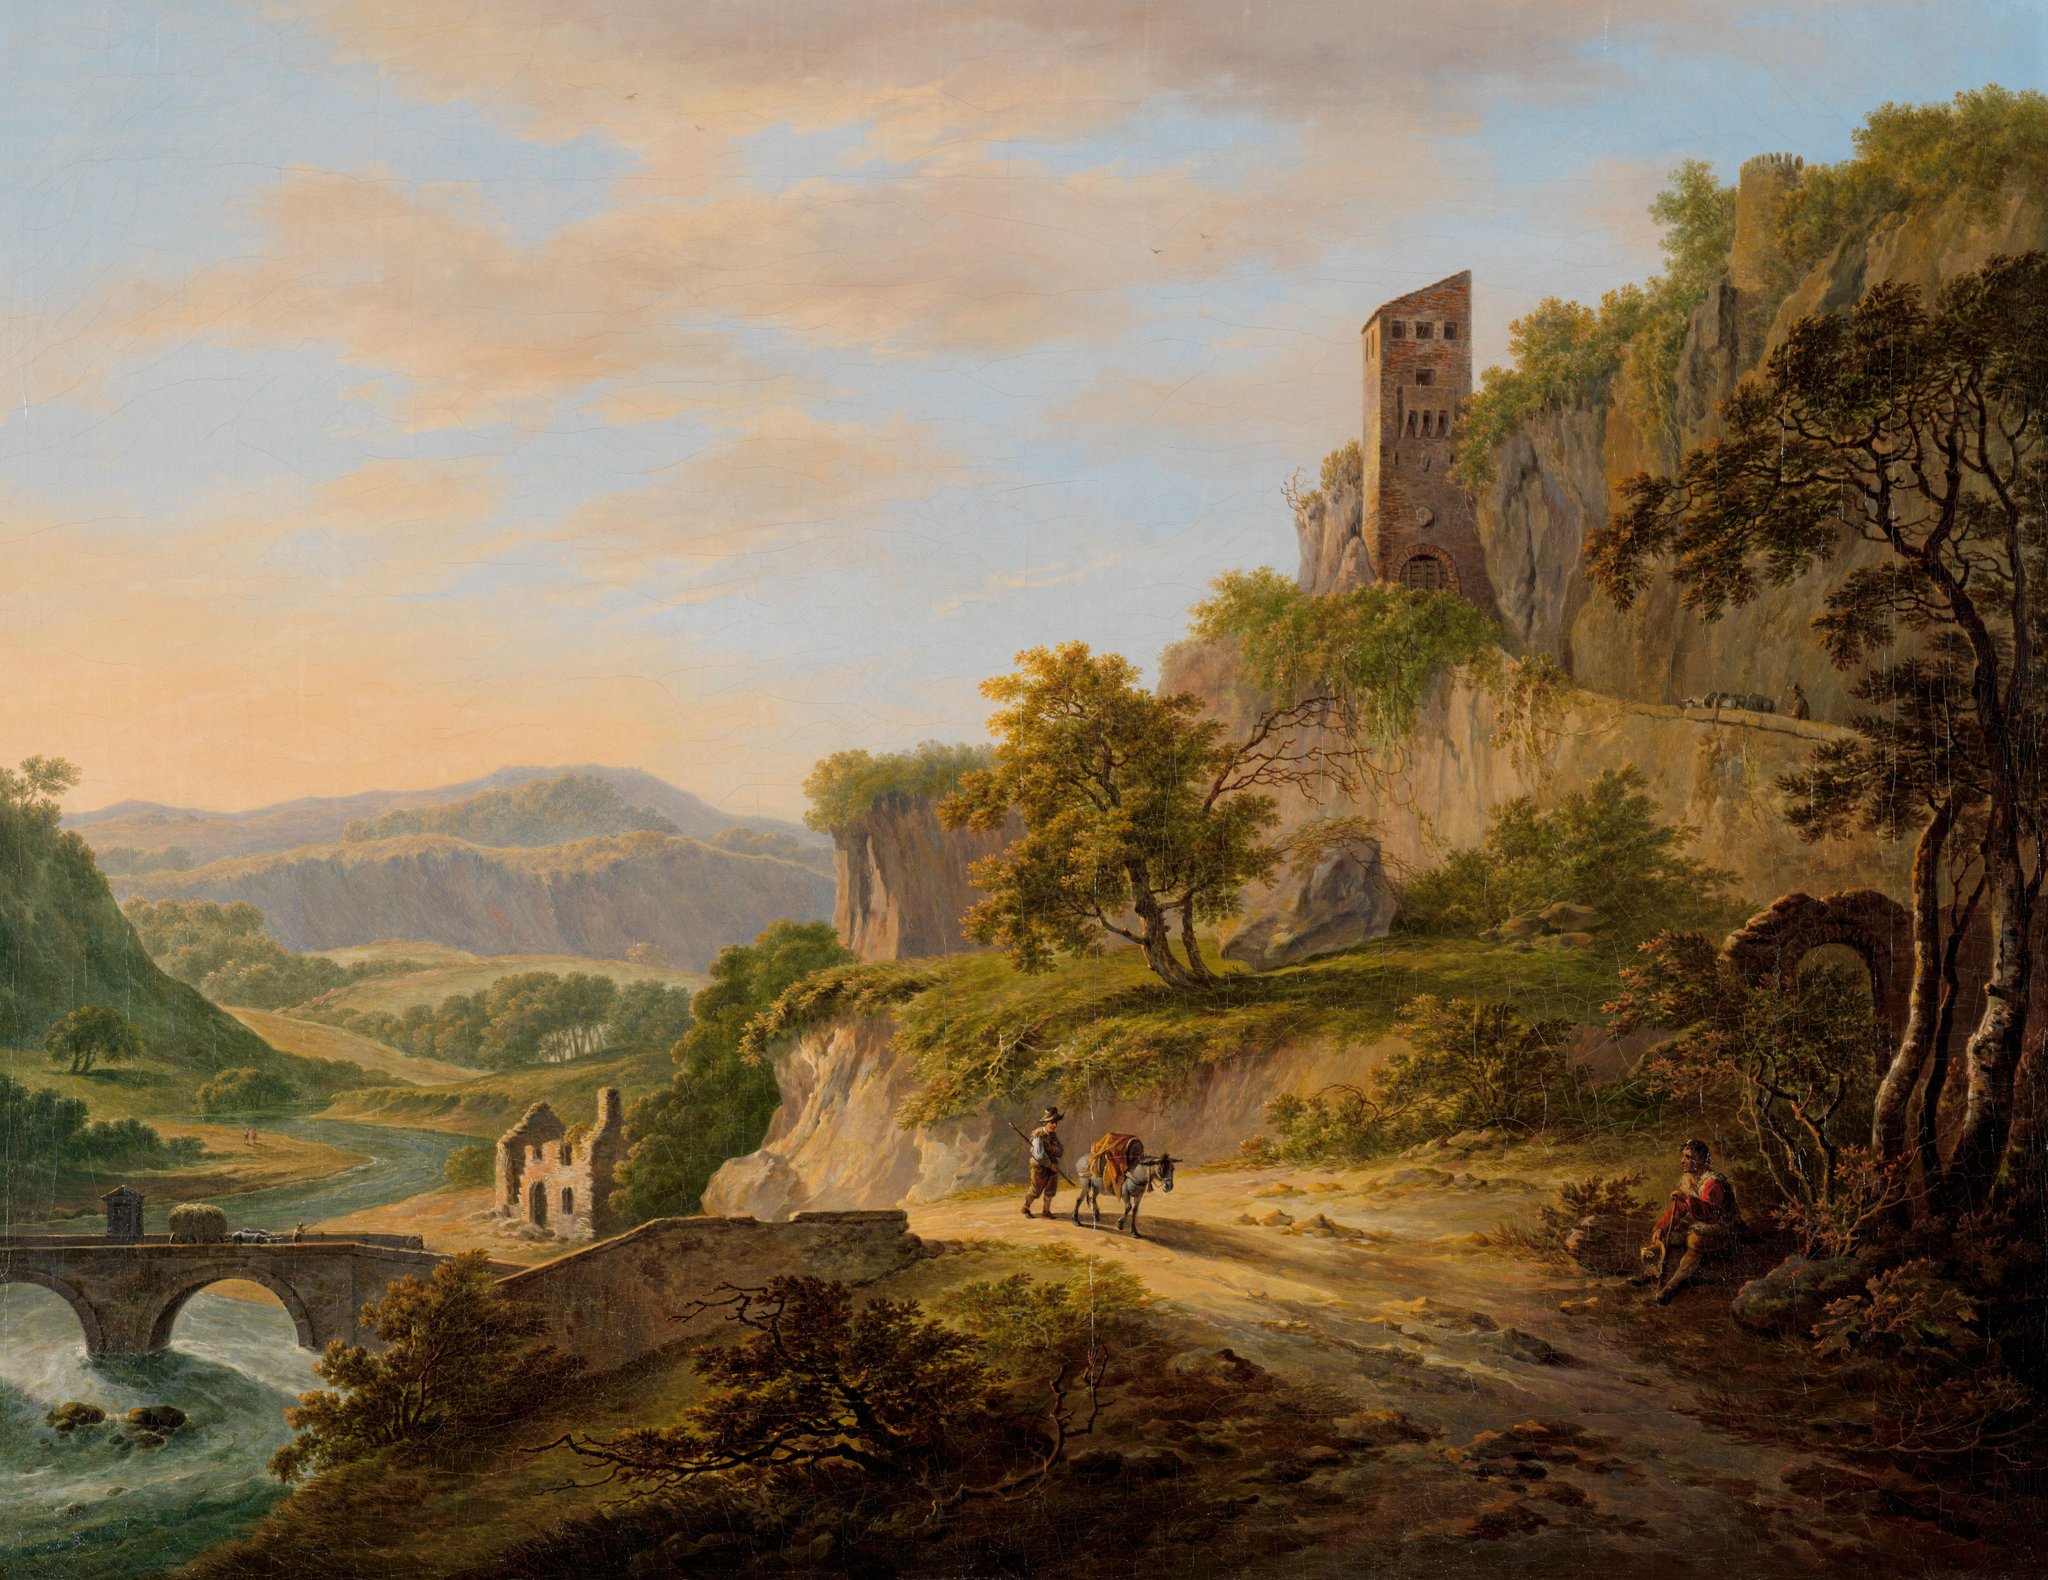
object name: painting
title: View of Civita Castellana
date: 1792-1809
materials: canvas, oil, paint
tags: landscape with ruins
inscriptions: signature: ‘D. du Pré f.’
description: In 1786, the Dutch artist Dupré went on a study trip to Rome. One of the places he visited along the way was Civita Castellana, an ancient Roman city north of Rome. He was fascinated by its location, high up on a jagged cliff, and so rather than painting the city itself he depicted the road leading to it. The sun has just risen and the rolling landscape – far away from bustling Rome – exudes an air of tranquillity.